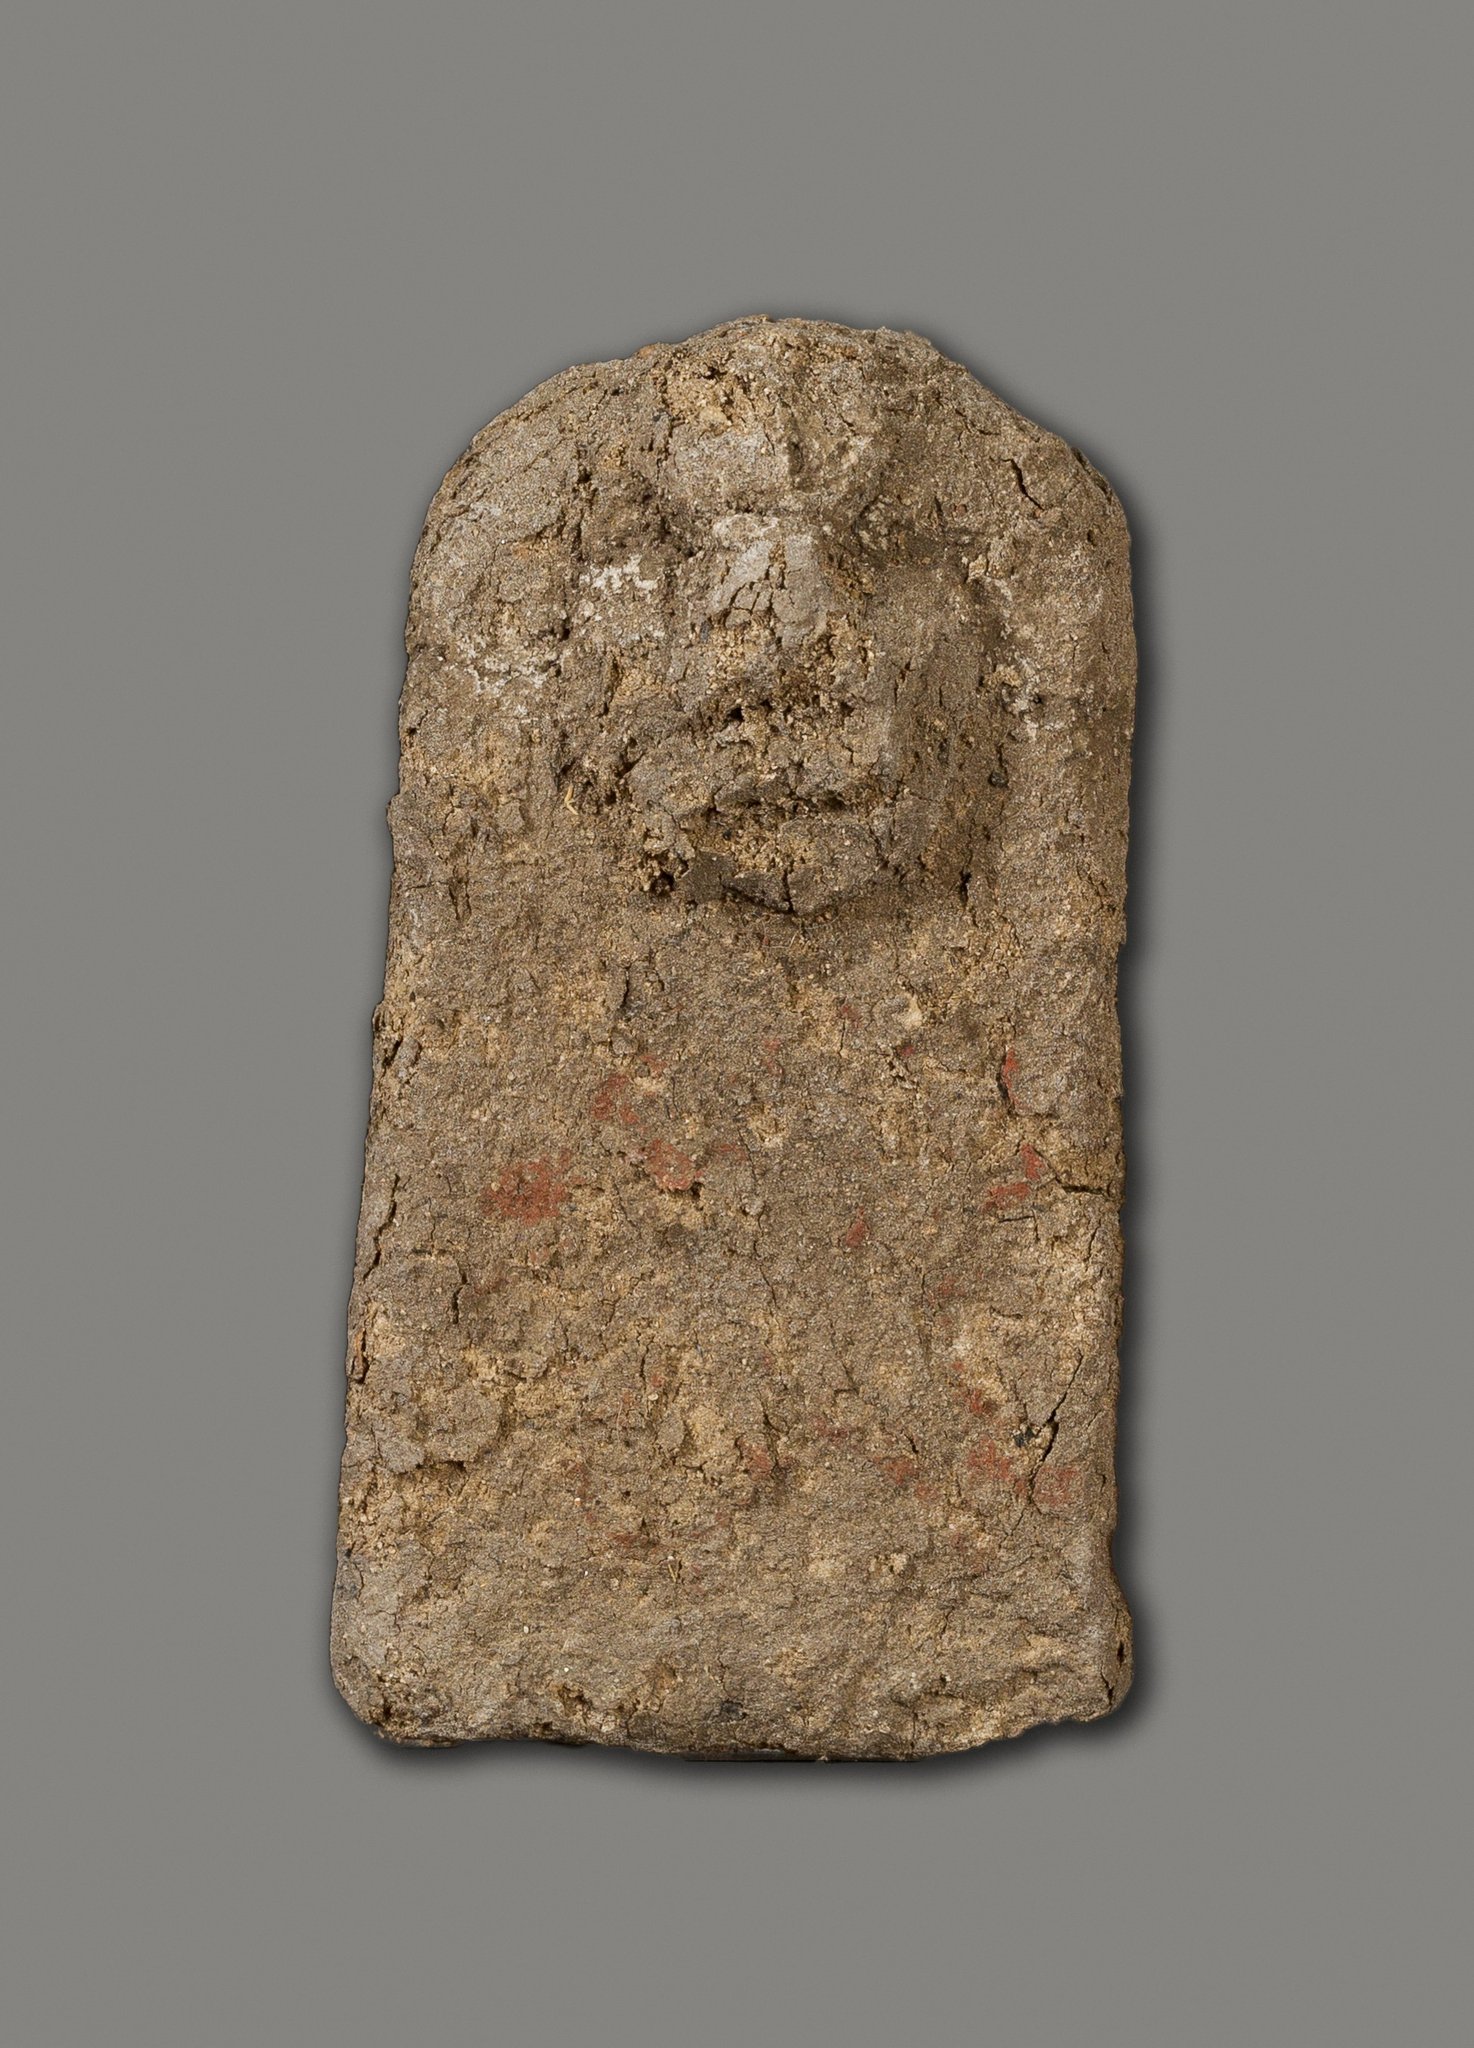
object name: figure, magical, execration, tablet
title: Magical Figure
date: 1802-1550 BCE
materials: clay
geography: egypt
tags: faces